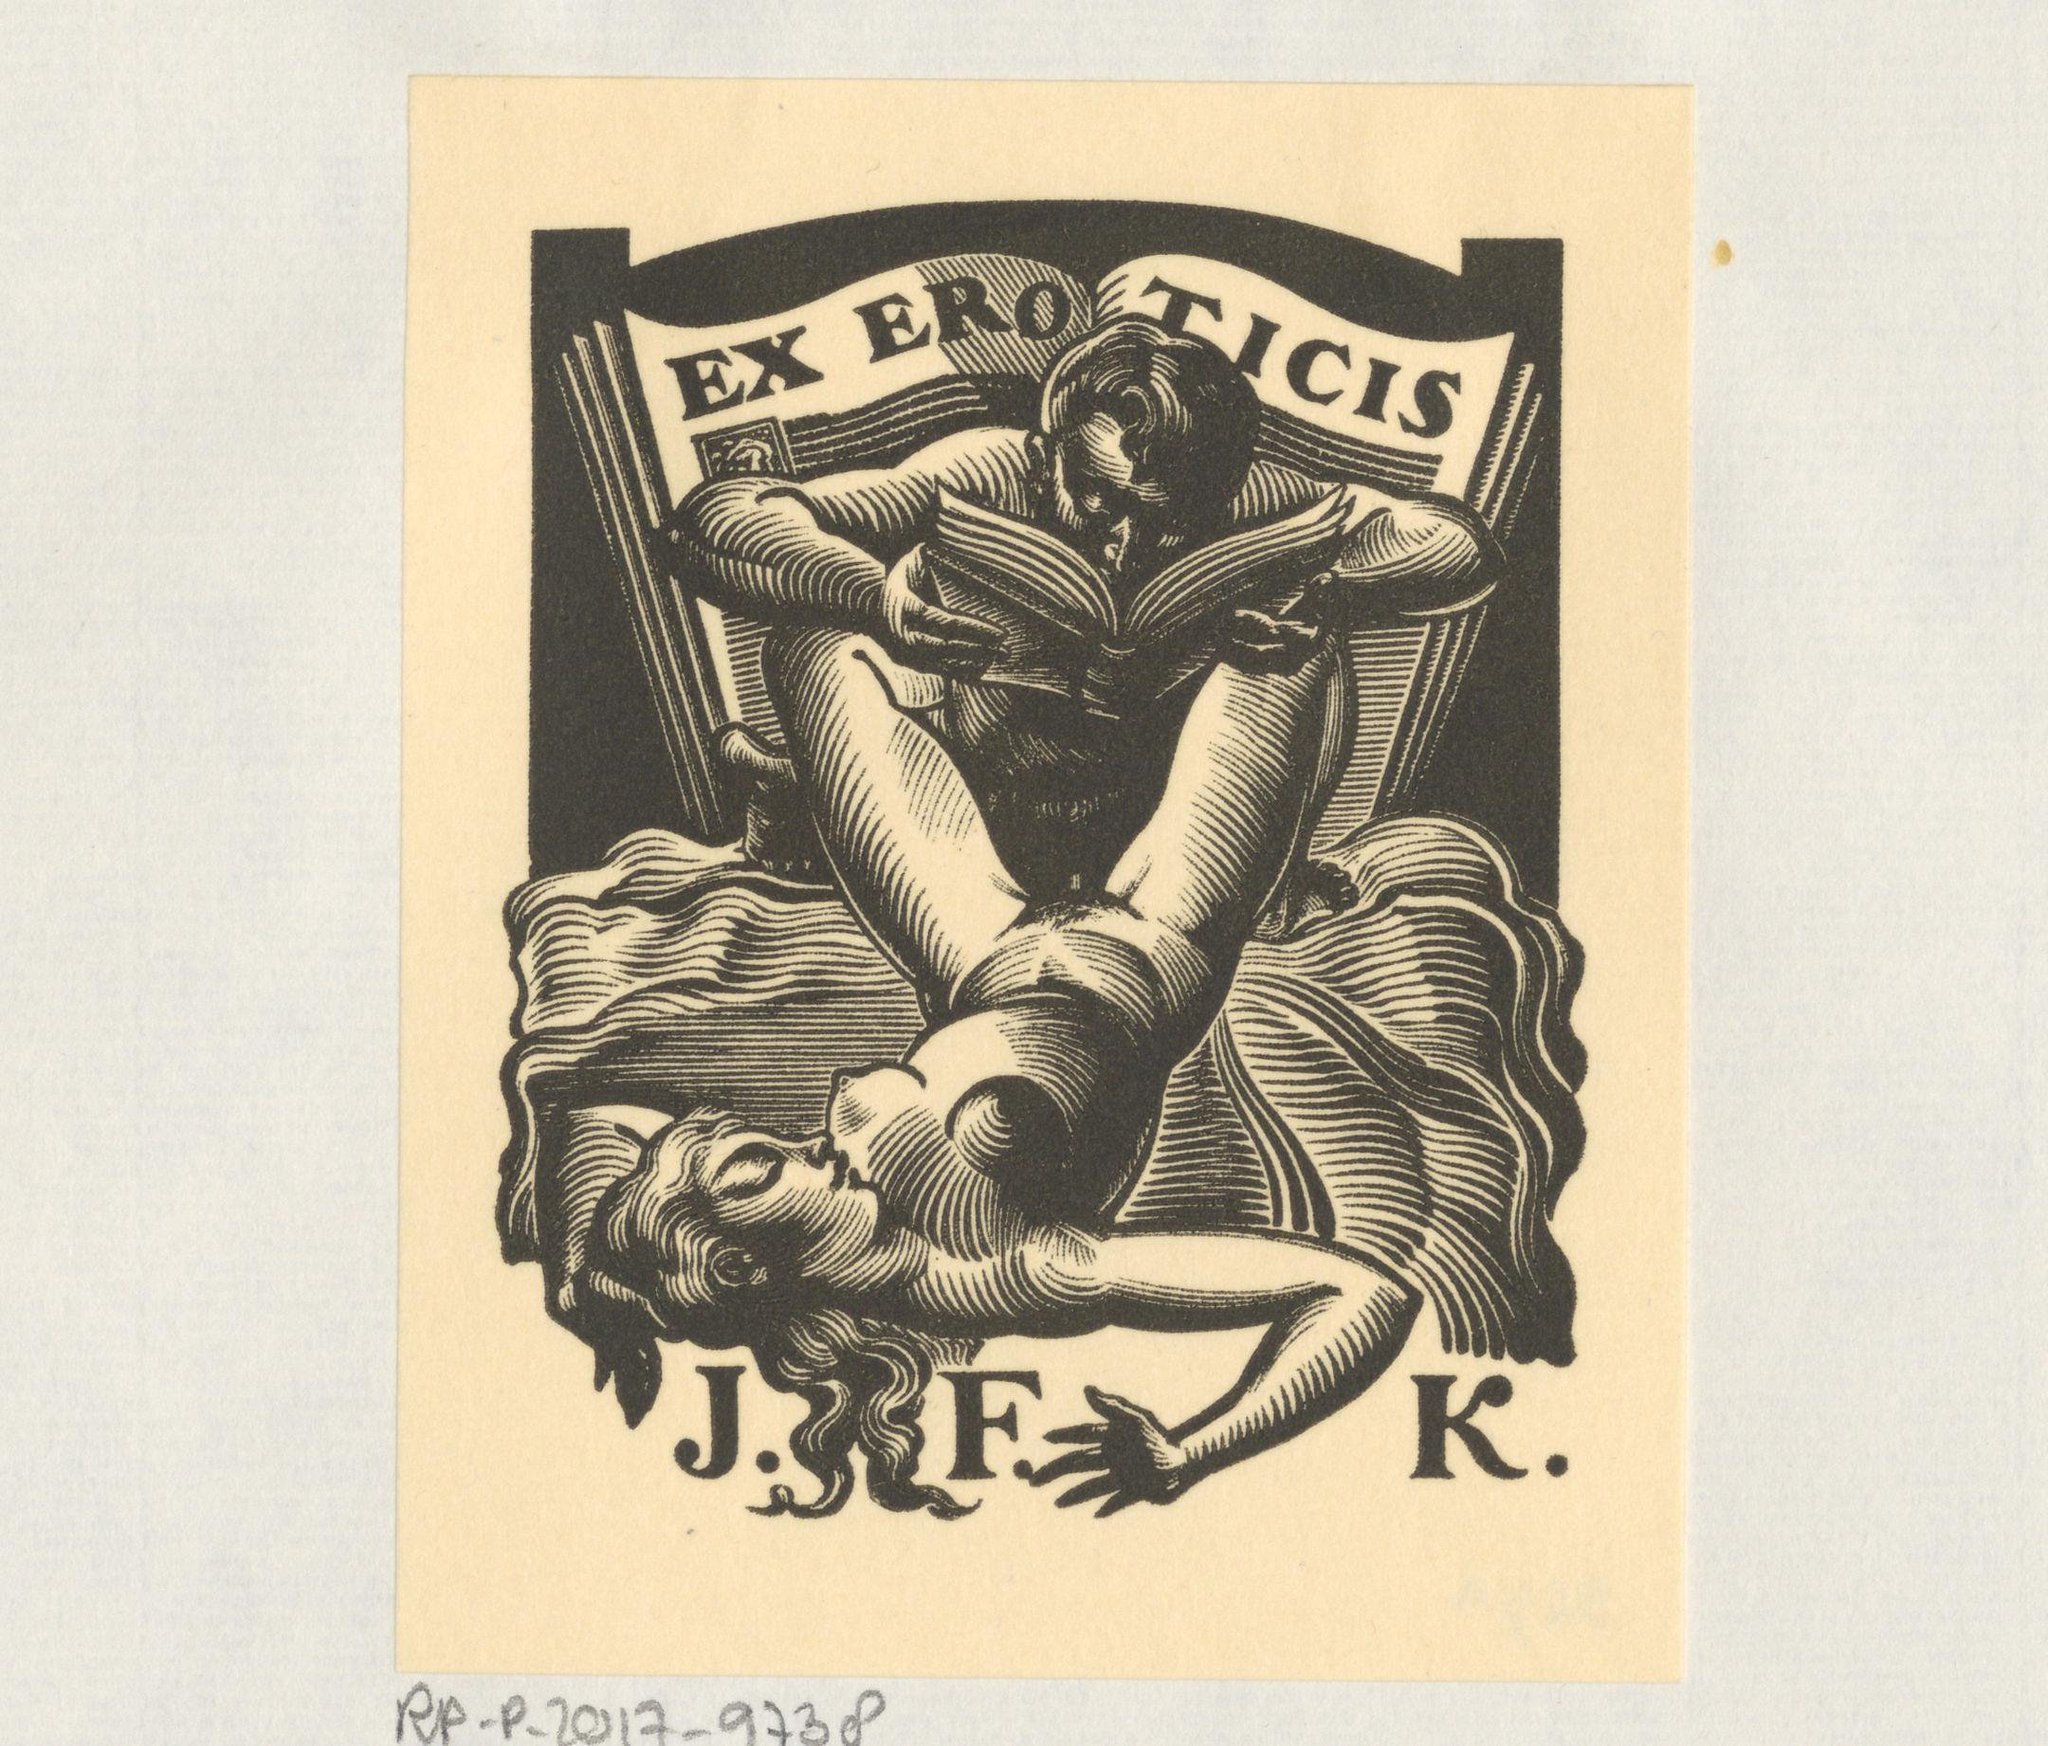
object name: bookplate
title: Ex libris van J.F. Käyser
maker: valentin le campion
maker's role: print maker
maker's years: 1861-1952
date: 1939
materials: paper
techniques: engraving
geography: france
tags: reading, woman (showing herself) undressed, quasi-nude, book